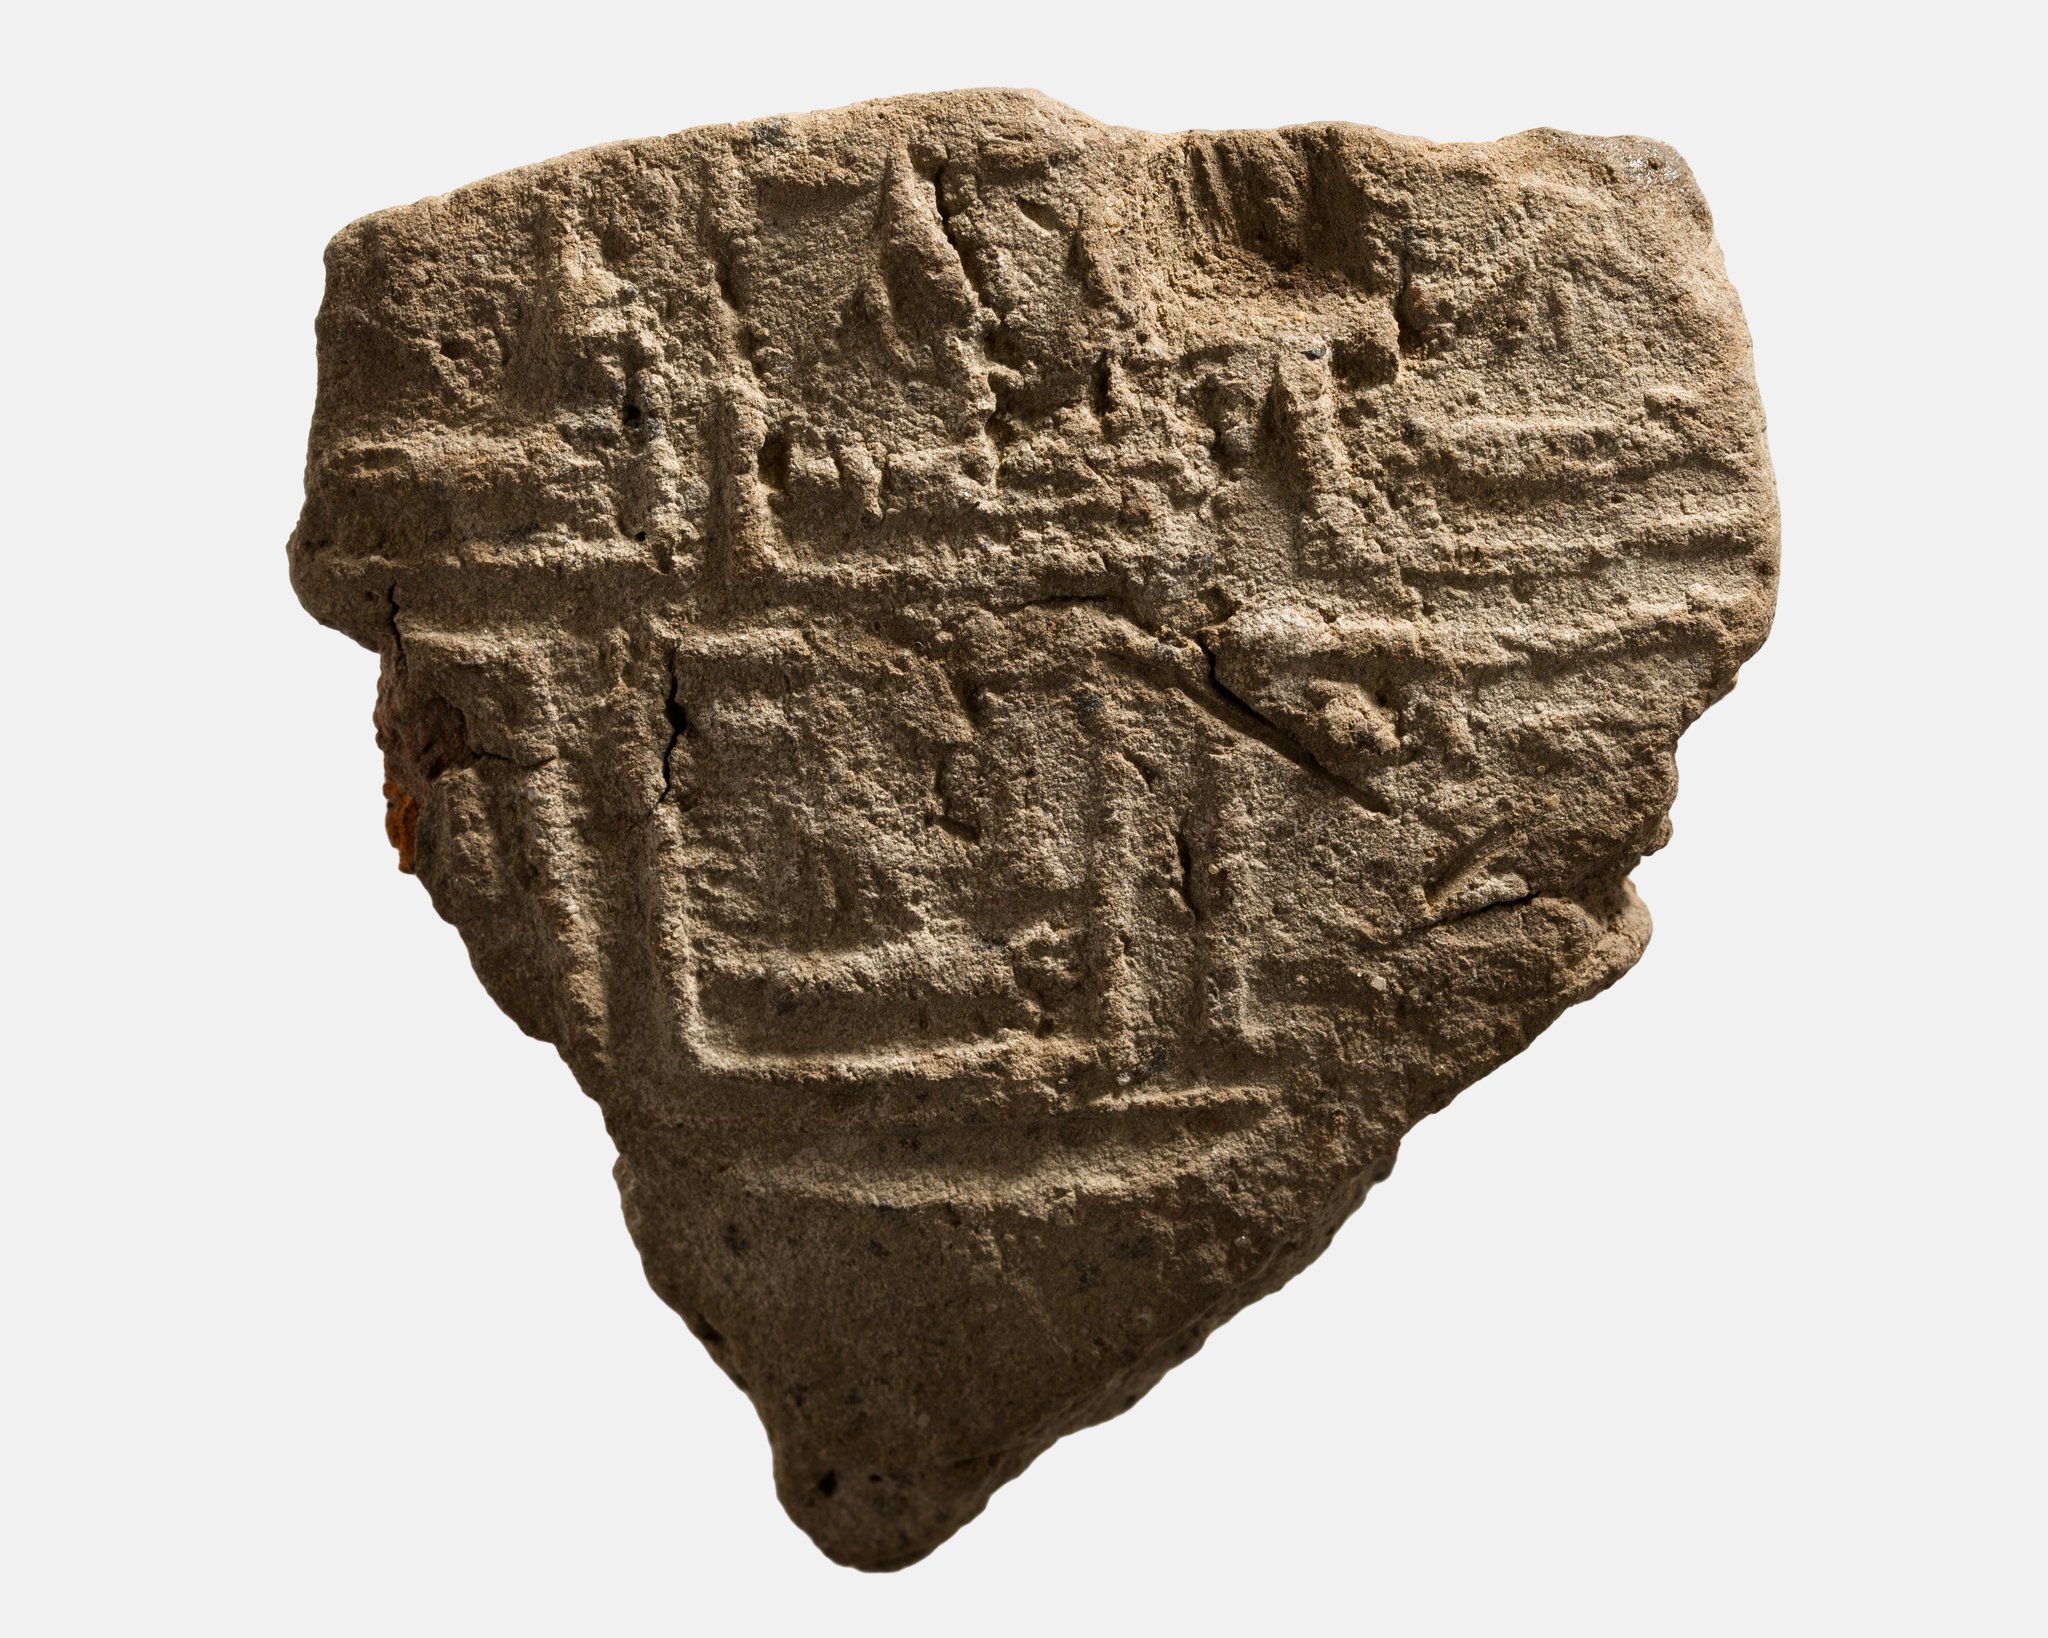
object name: sealing, jar, king narmer's estate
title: Mud jar sealing indicating King Narmer's estate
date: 3100 BCE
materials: clay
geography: egypt